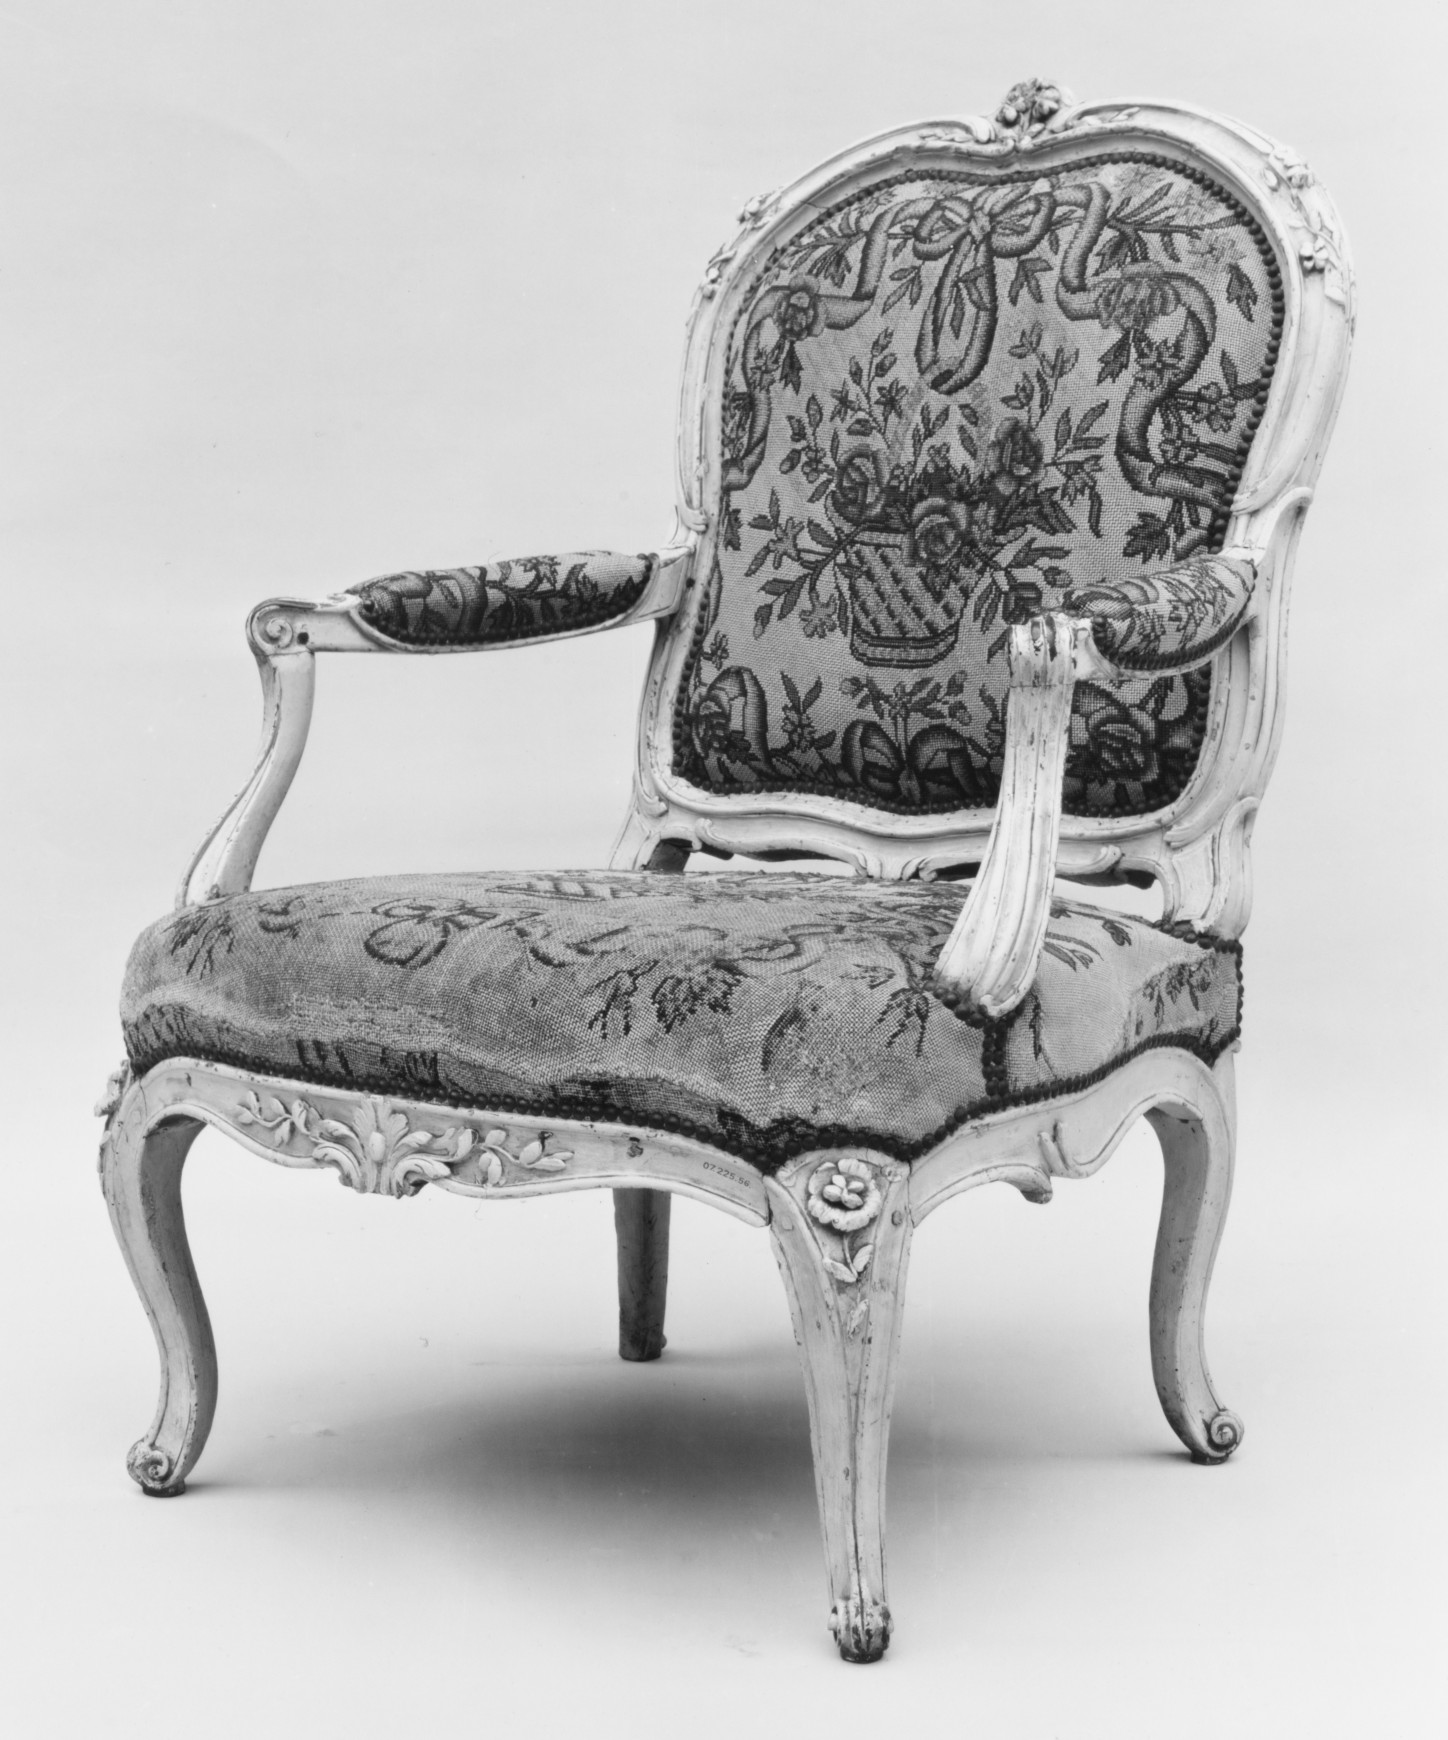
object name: armchair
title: Armchair (fauteuil)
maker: nicolas heurtaut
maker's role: maker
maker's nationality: french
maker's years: 1720-1771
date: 1701-1800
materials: silk, wood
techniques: carving, painting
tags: roses